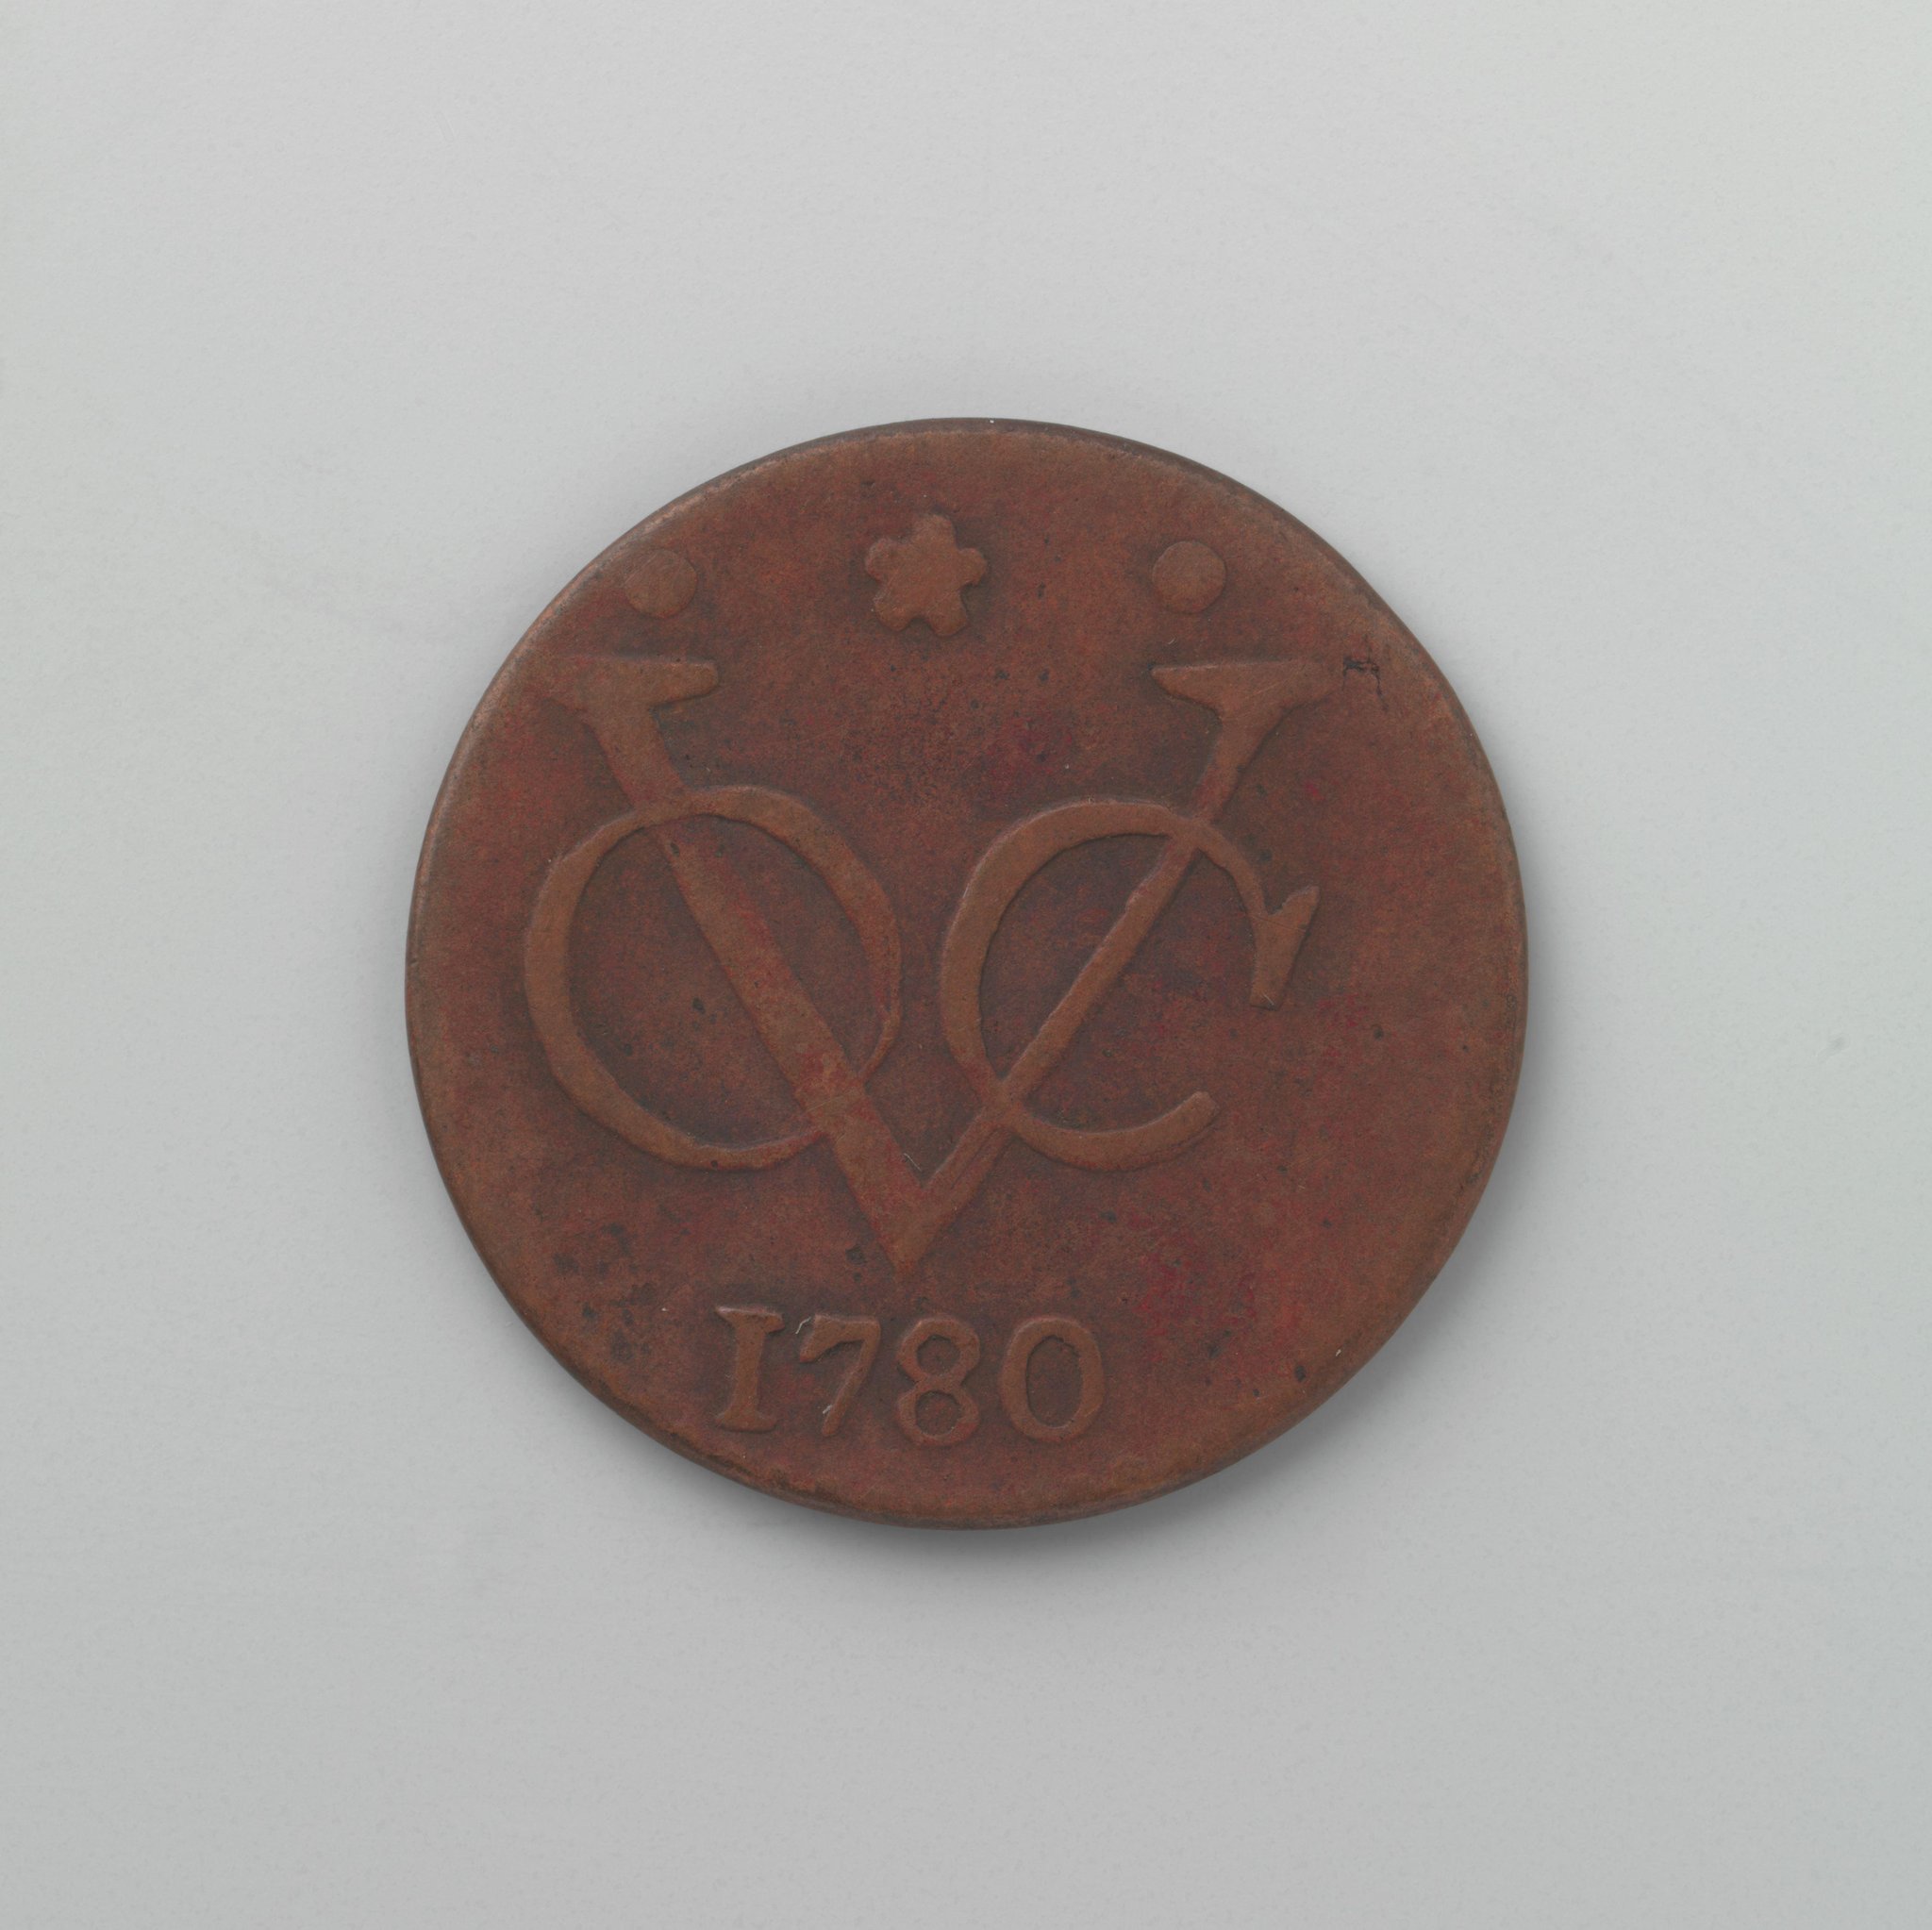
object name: coin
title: VOC, duit Westfriesland, 1780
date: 1780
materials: copper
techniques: striking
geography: medemblik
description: Koperen munt. Voorzijde: gekroond wapenschild van Westfriesland. Keerzijde: monogram van de VOC, waarboven muntteken en waaronder jaartal. Gladde rand.